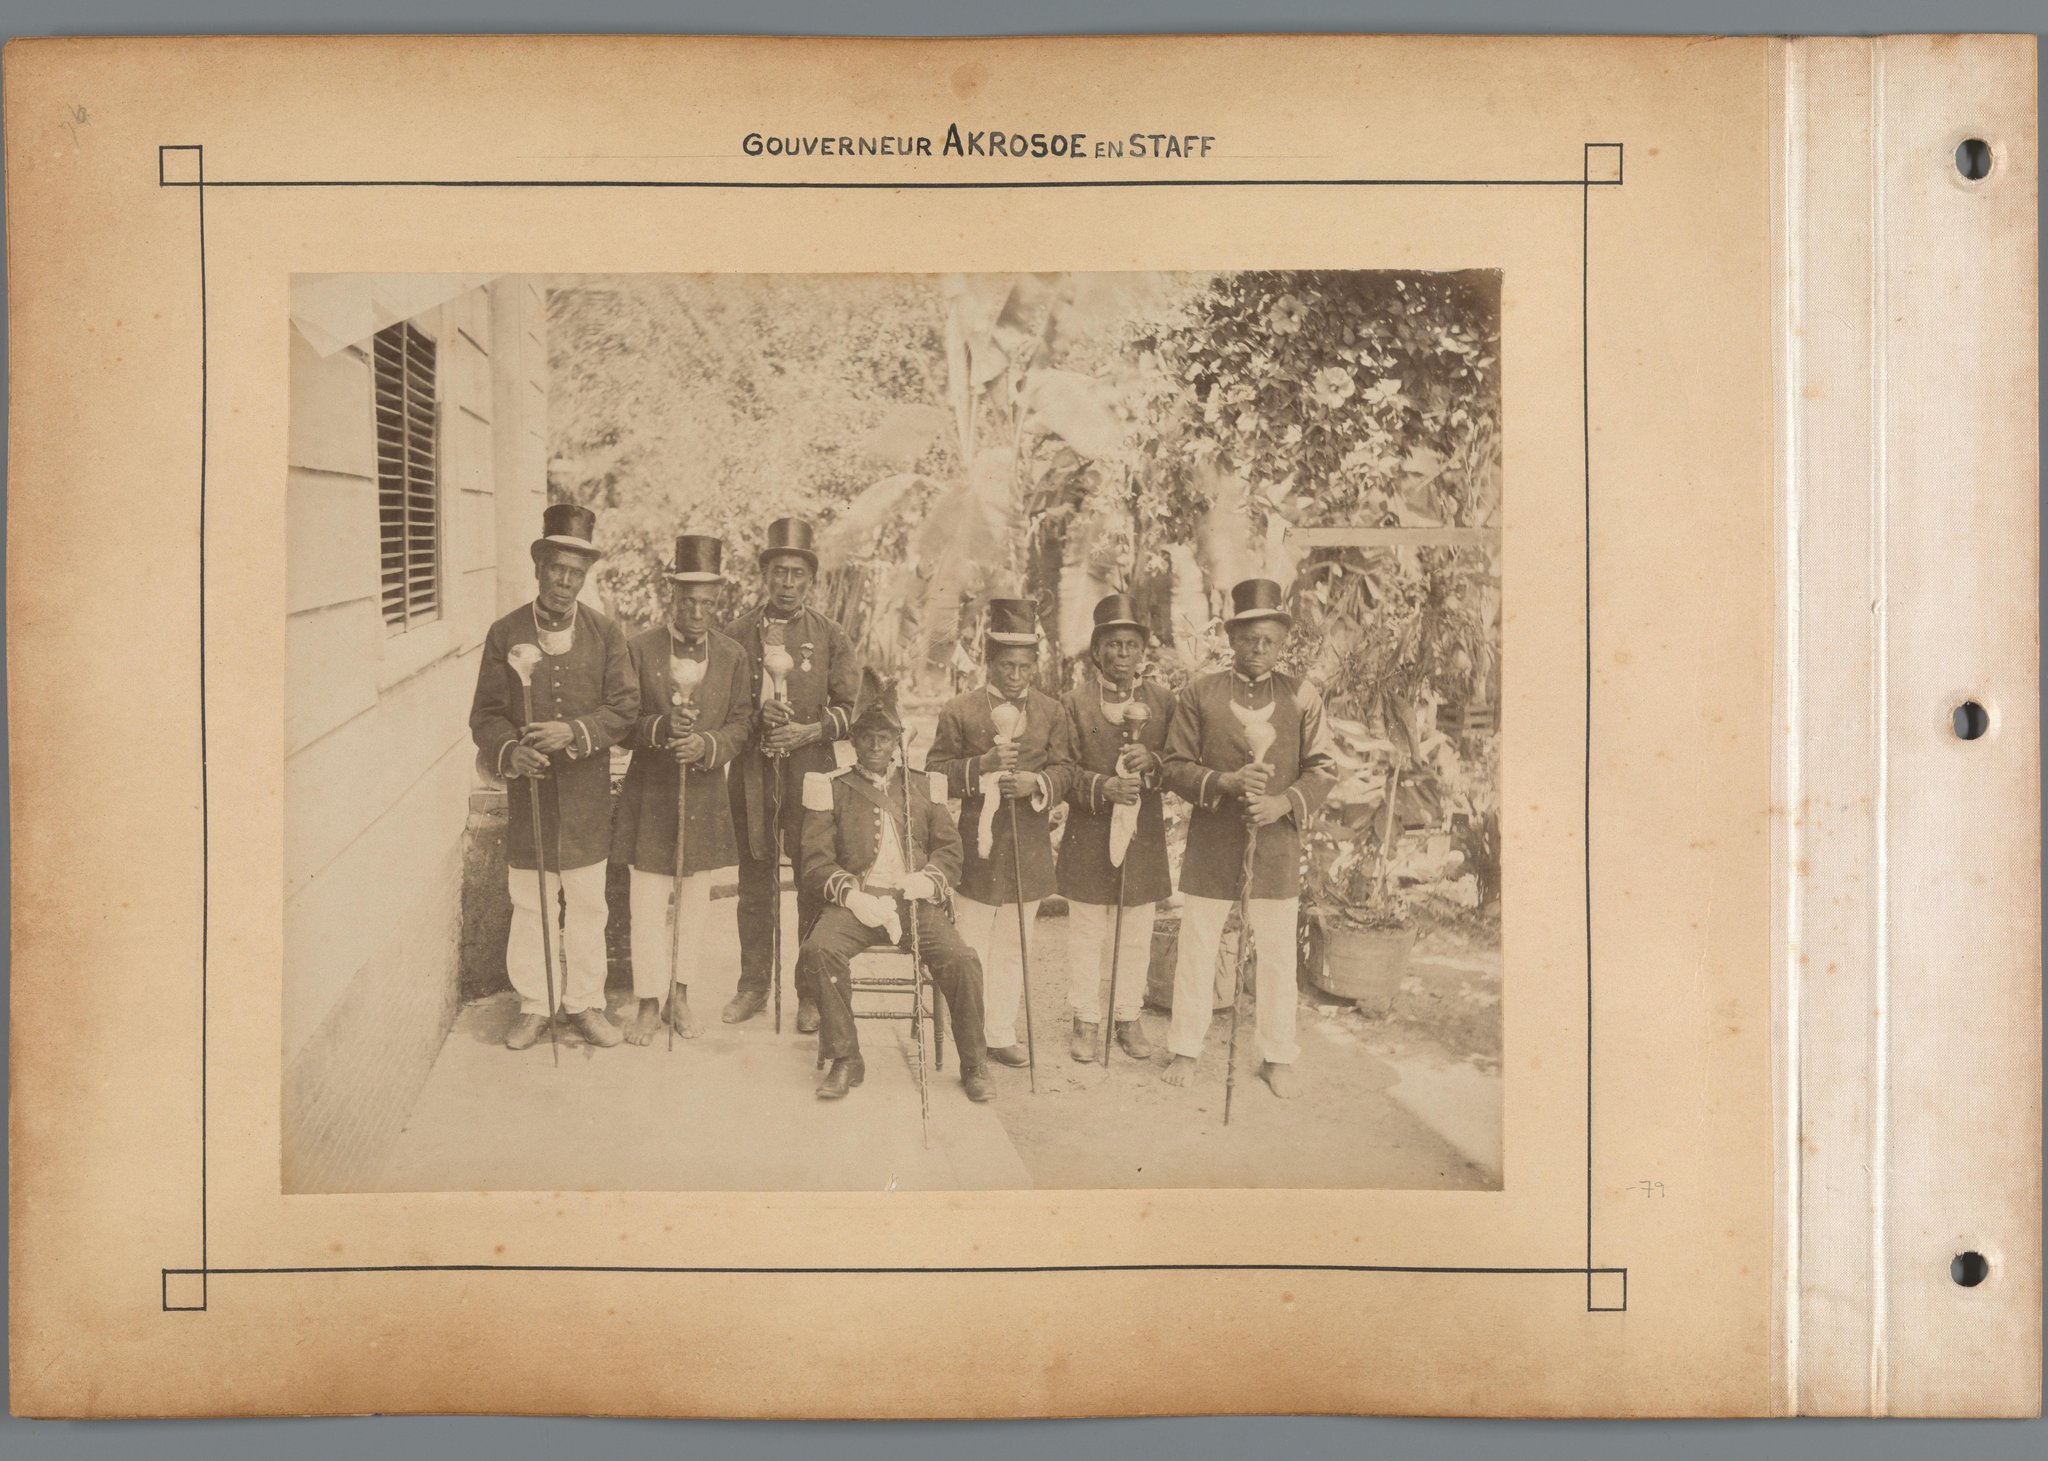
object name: photograph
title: Gouverneur Akrosoe en staff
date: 1898-1902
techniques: albumen print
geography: suriname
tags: suriname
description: Gouverneur (of kapitein?) Akrosoe poserend met zijn staf op de veranda van een gebouw.